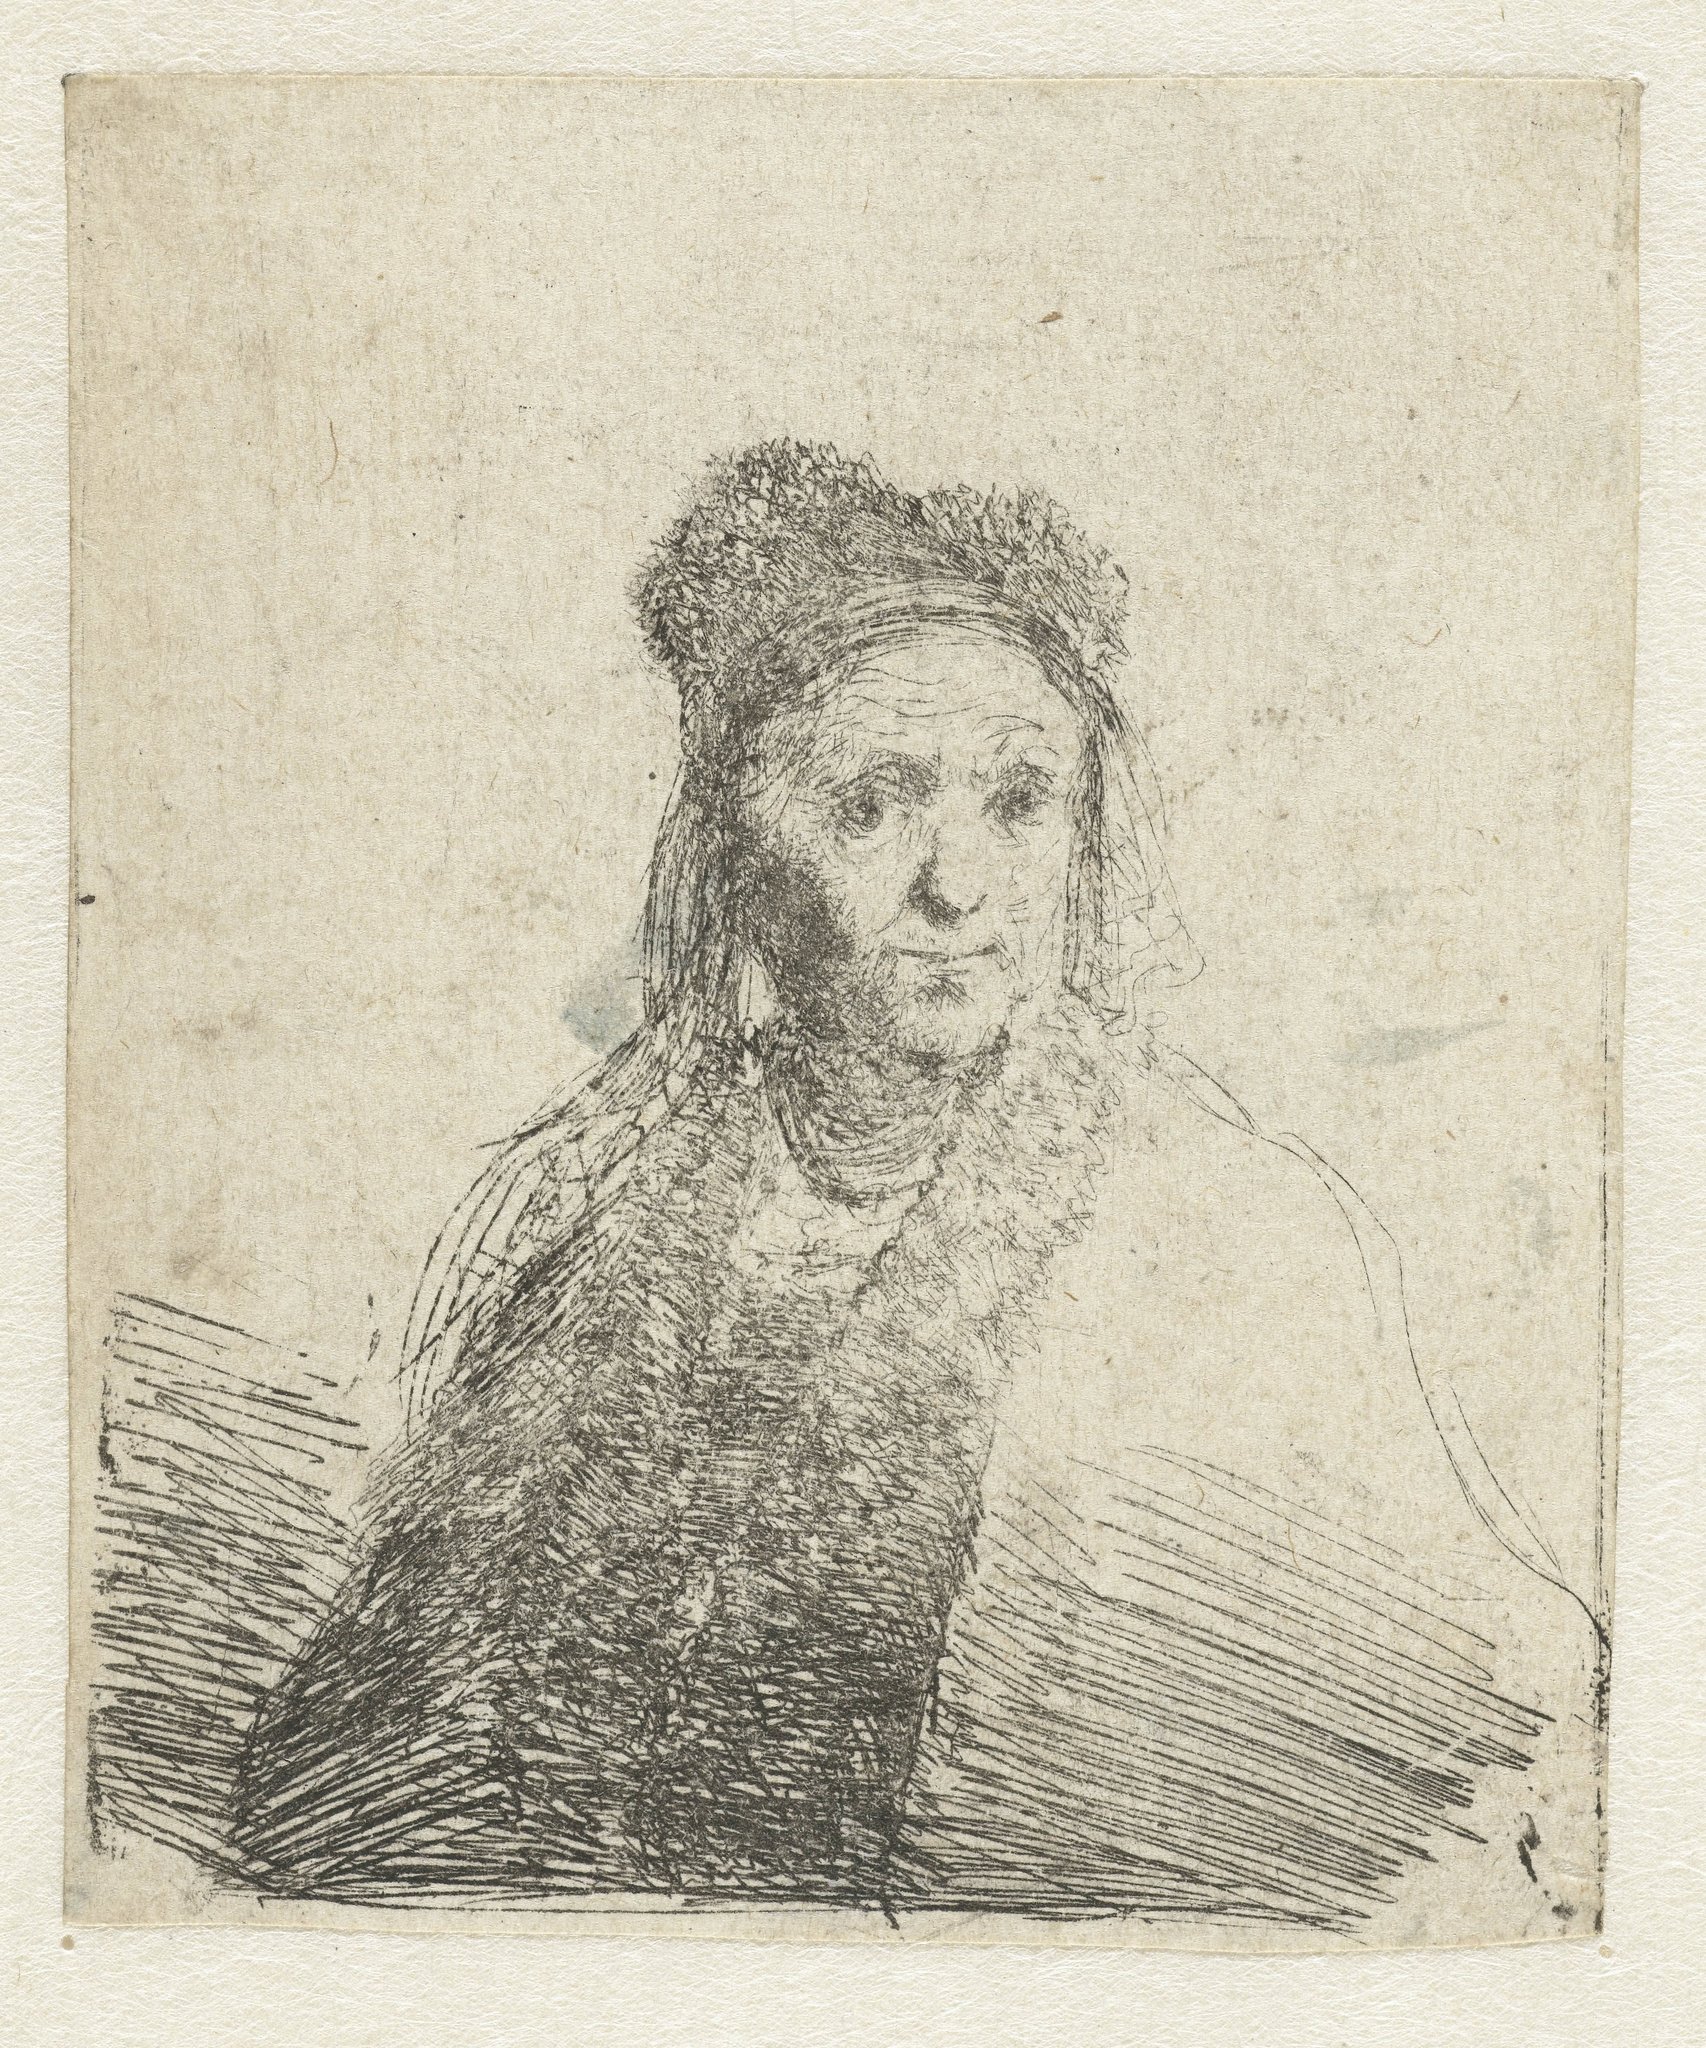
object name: print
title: Portret van een oude vrouw met bontmuts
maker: jan lievens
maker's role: draughtsman, painter, print maker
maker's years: 1607-1674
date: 1625-1674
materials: paper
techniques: etching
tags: head-gear: cap (+ women's clothes), old woman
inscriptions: collector's mark: Lugt 2227